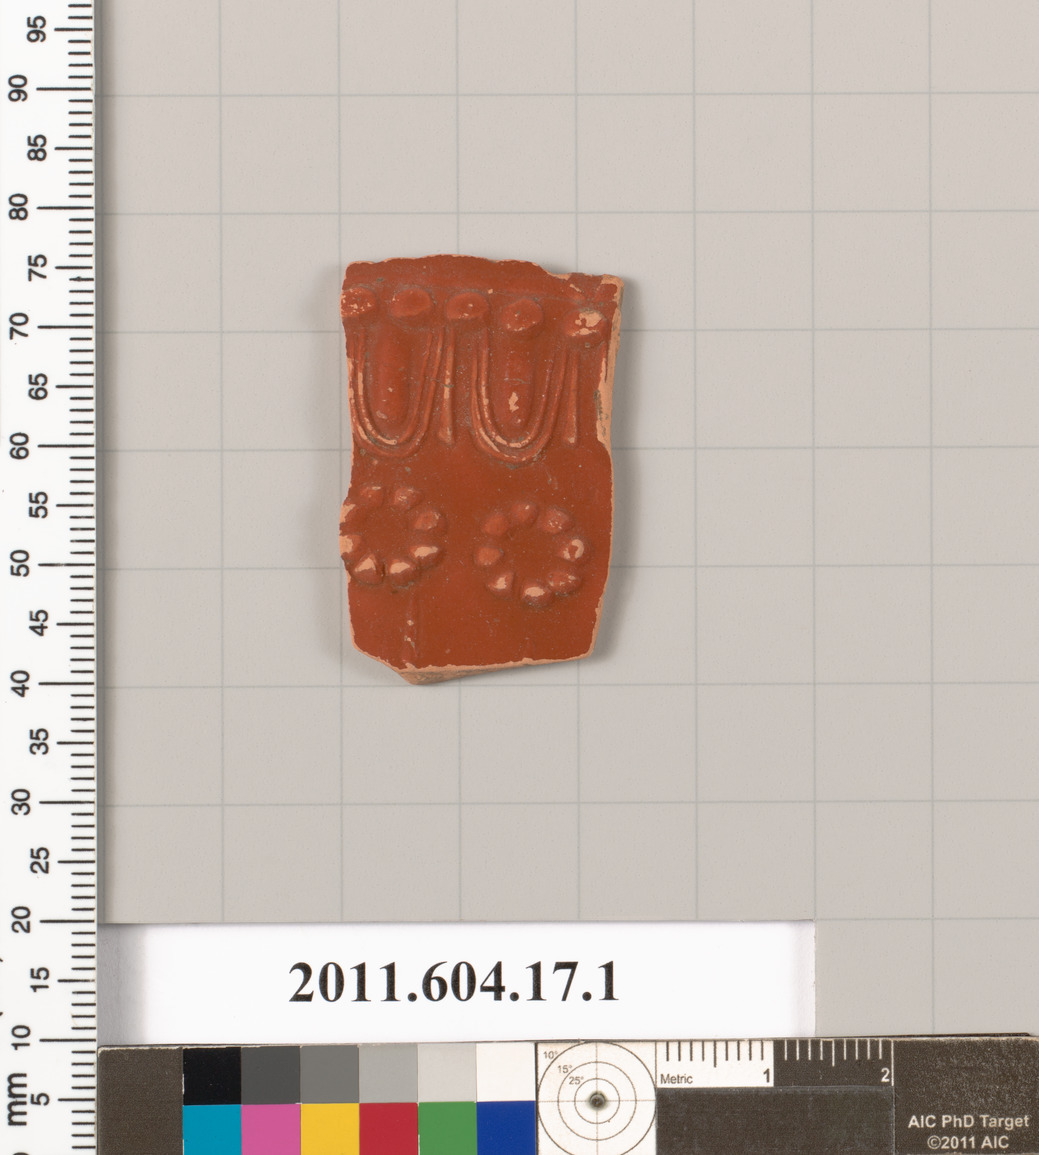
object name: fragment of a bowl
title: Terracotta fragment of a bowl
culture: roman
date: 101-200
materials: terracotta